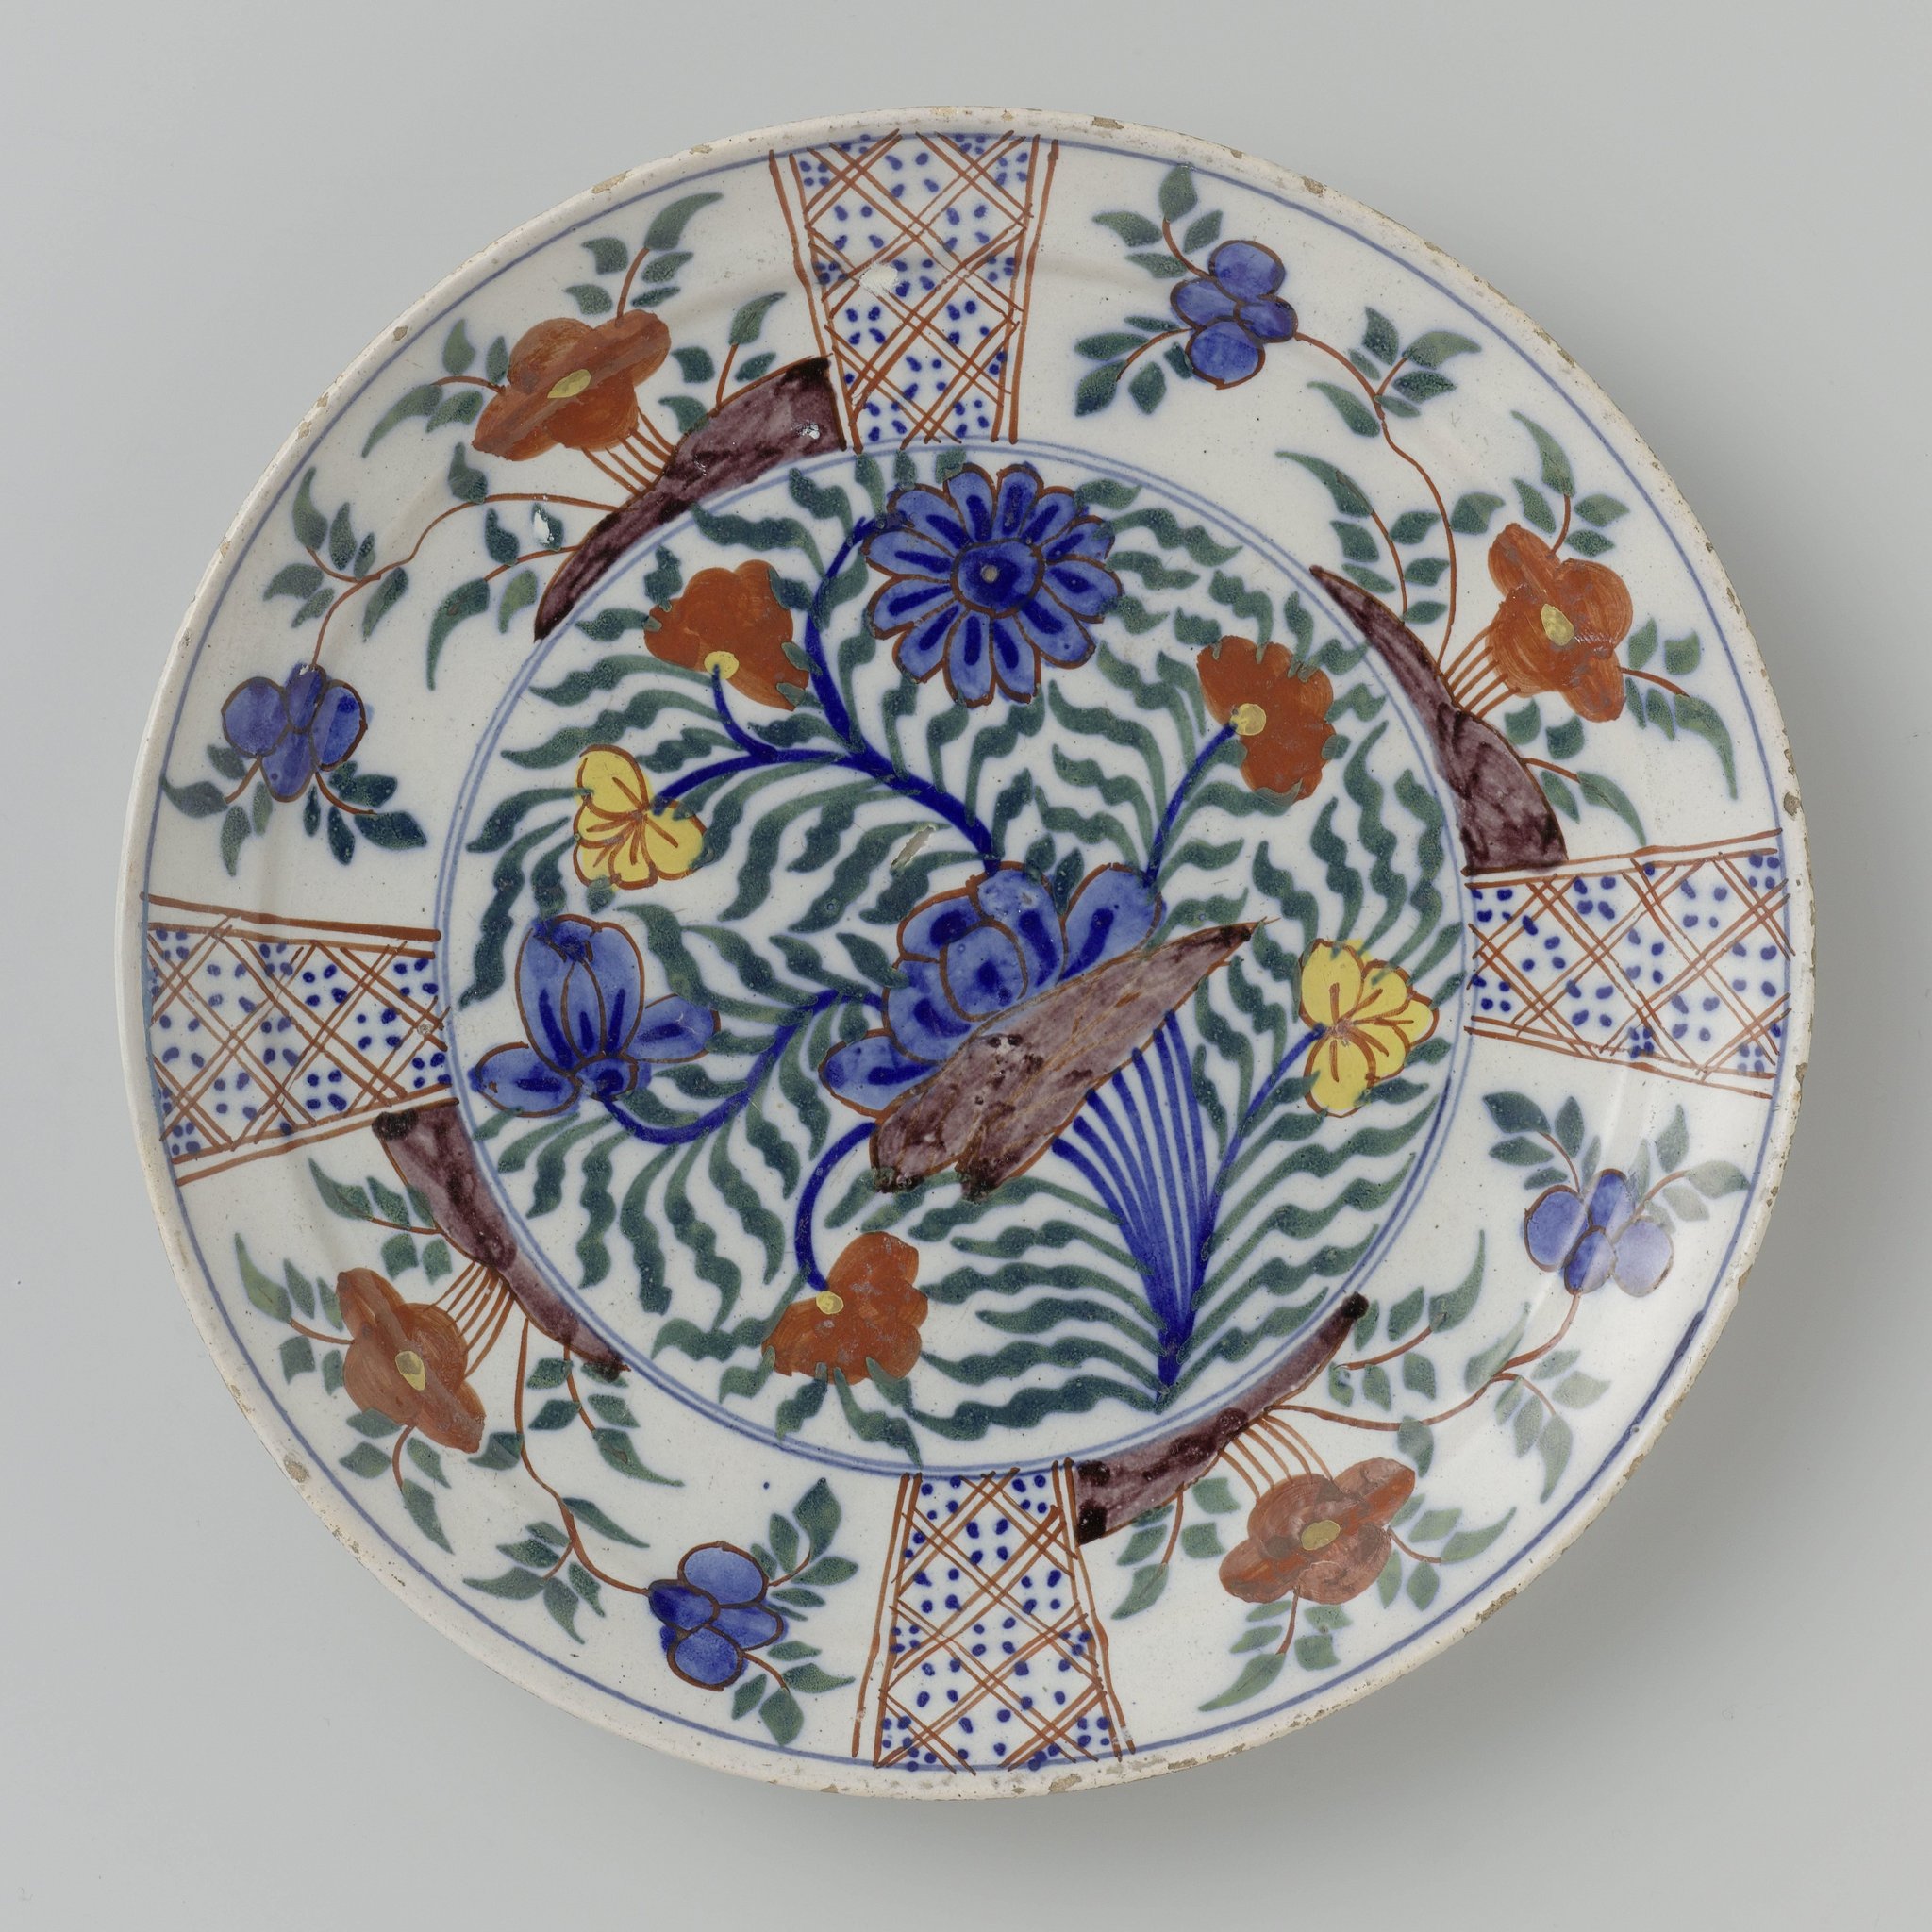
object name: plate dish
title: Bord van gepolychromeerde faience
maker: Anonymous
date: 1750-1780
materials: earthenware, glaze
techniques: painted, polychromy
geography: delft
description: Rond bord van veelkleurig beschilderde faience. Het plat is beschilderd met bloemen en de rand is verdeeld in vakken. In vier grote vakken zijn bloemen geschilderd en in vier smalle vakken een Chinees motief.